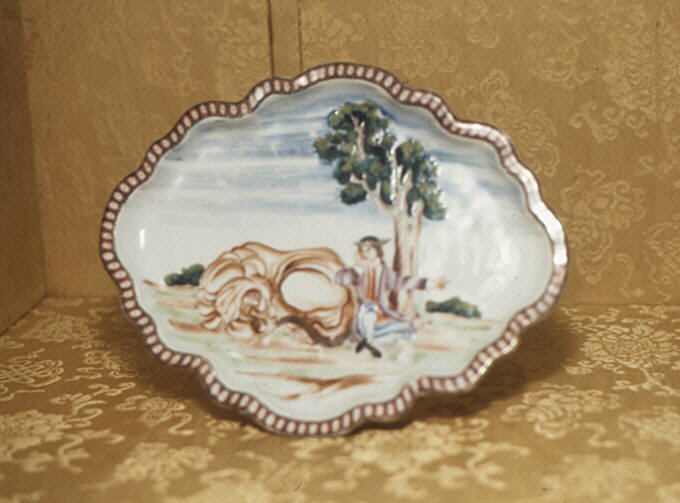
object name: tray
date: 1770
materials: hard paste porcelain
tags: men,trees